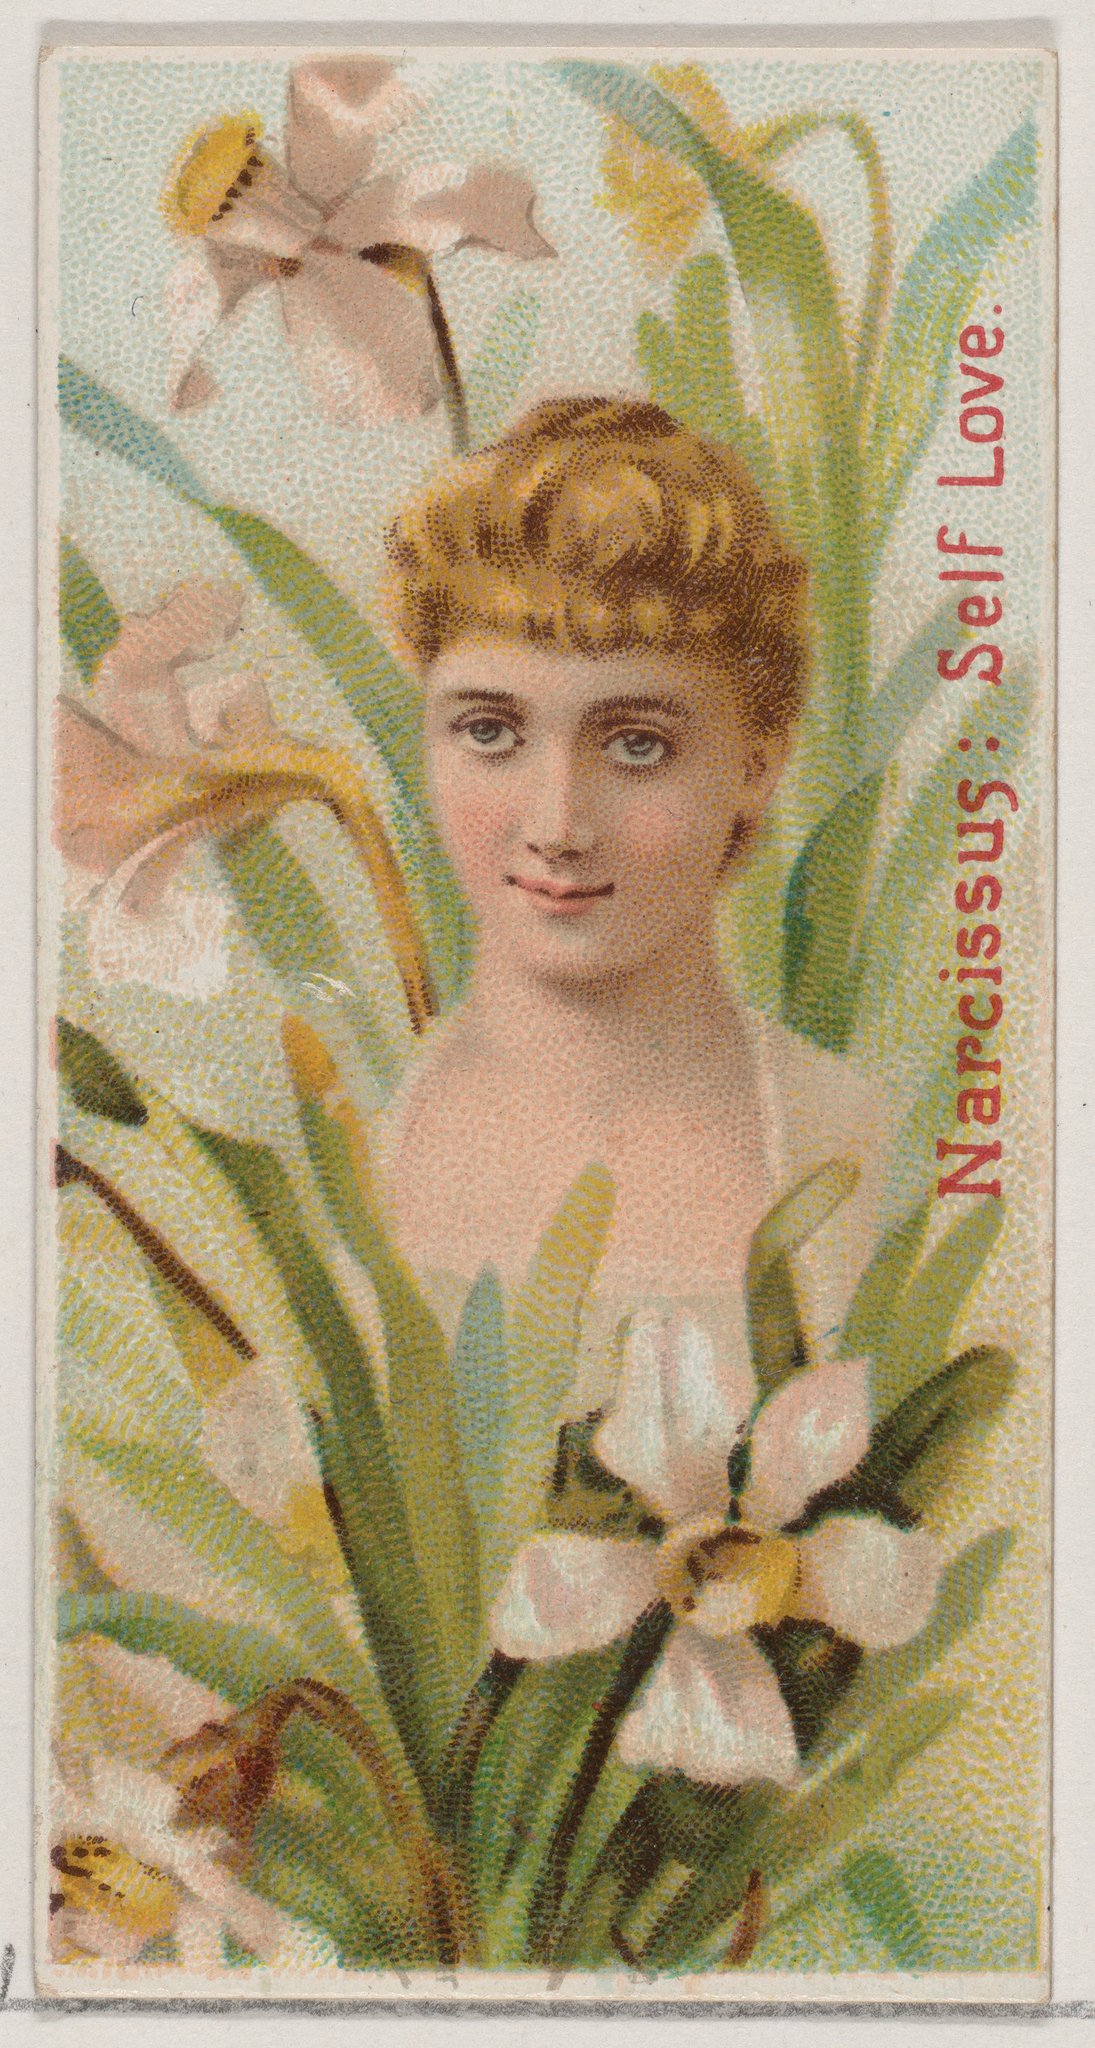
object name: print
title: Narcissus: Self Love, from the series Floral Beauties and Language of Flowers (N75) for Duke brand cigarettes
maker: american tobacco company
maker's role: publisher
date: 1892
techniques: color lithograph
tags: women,flowers